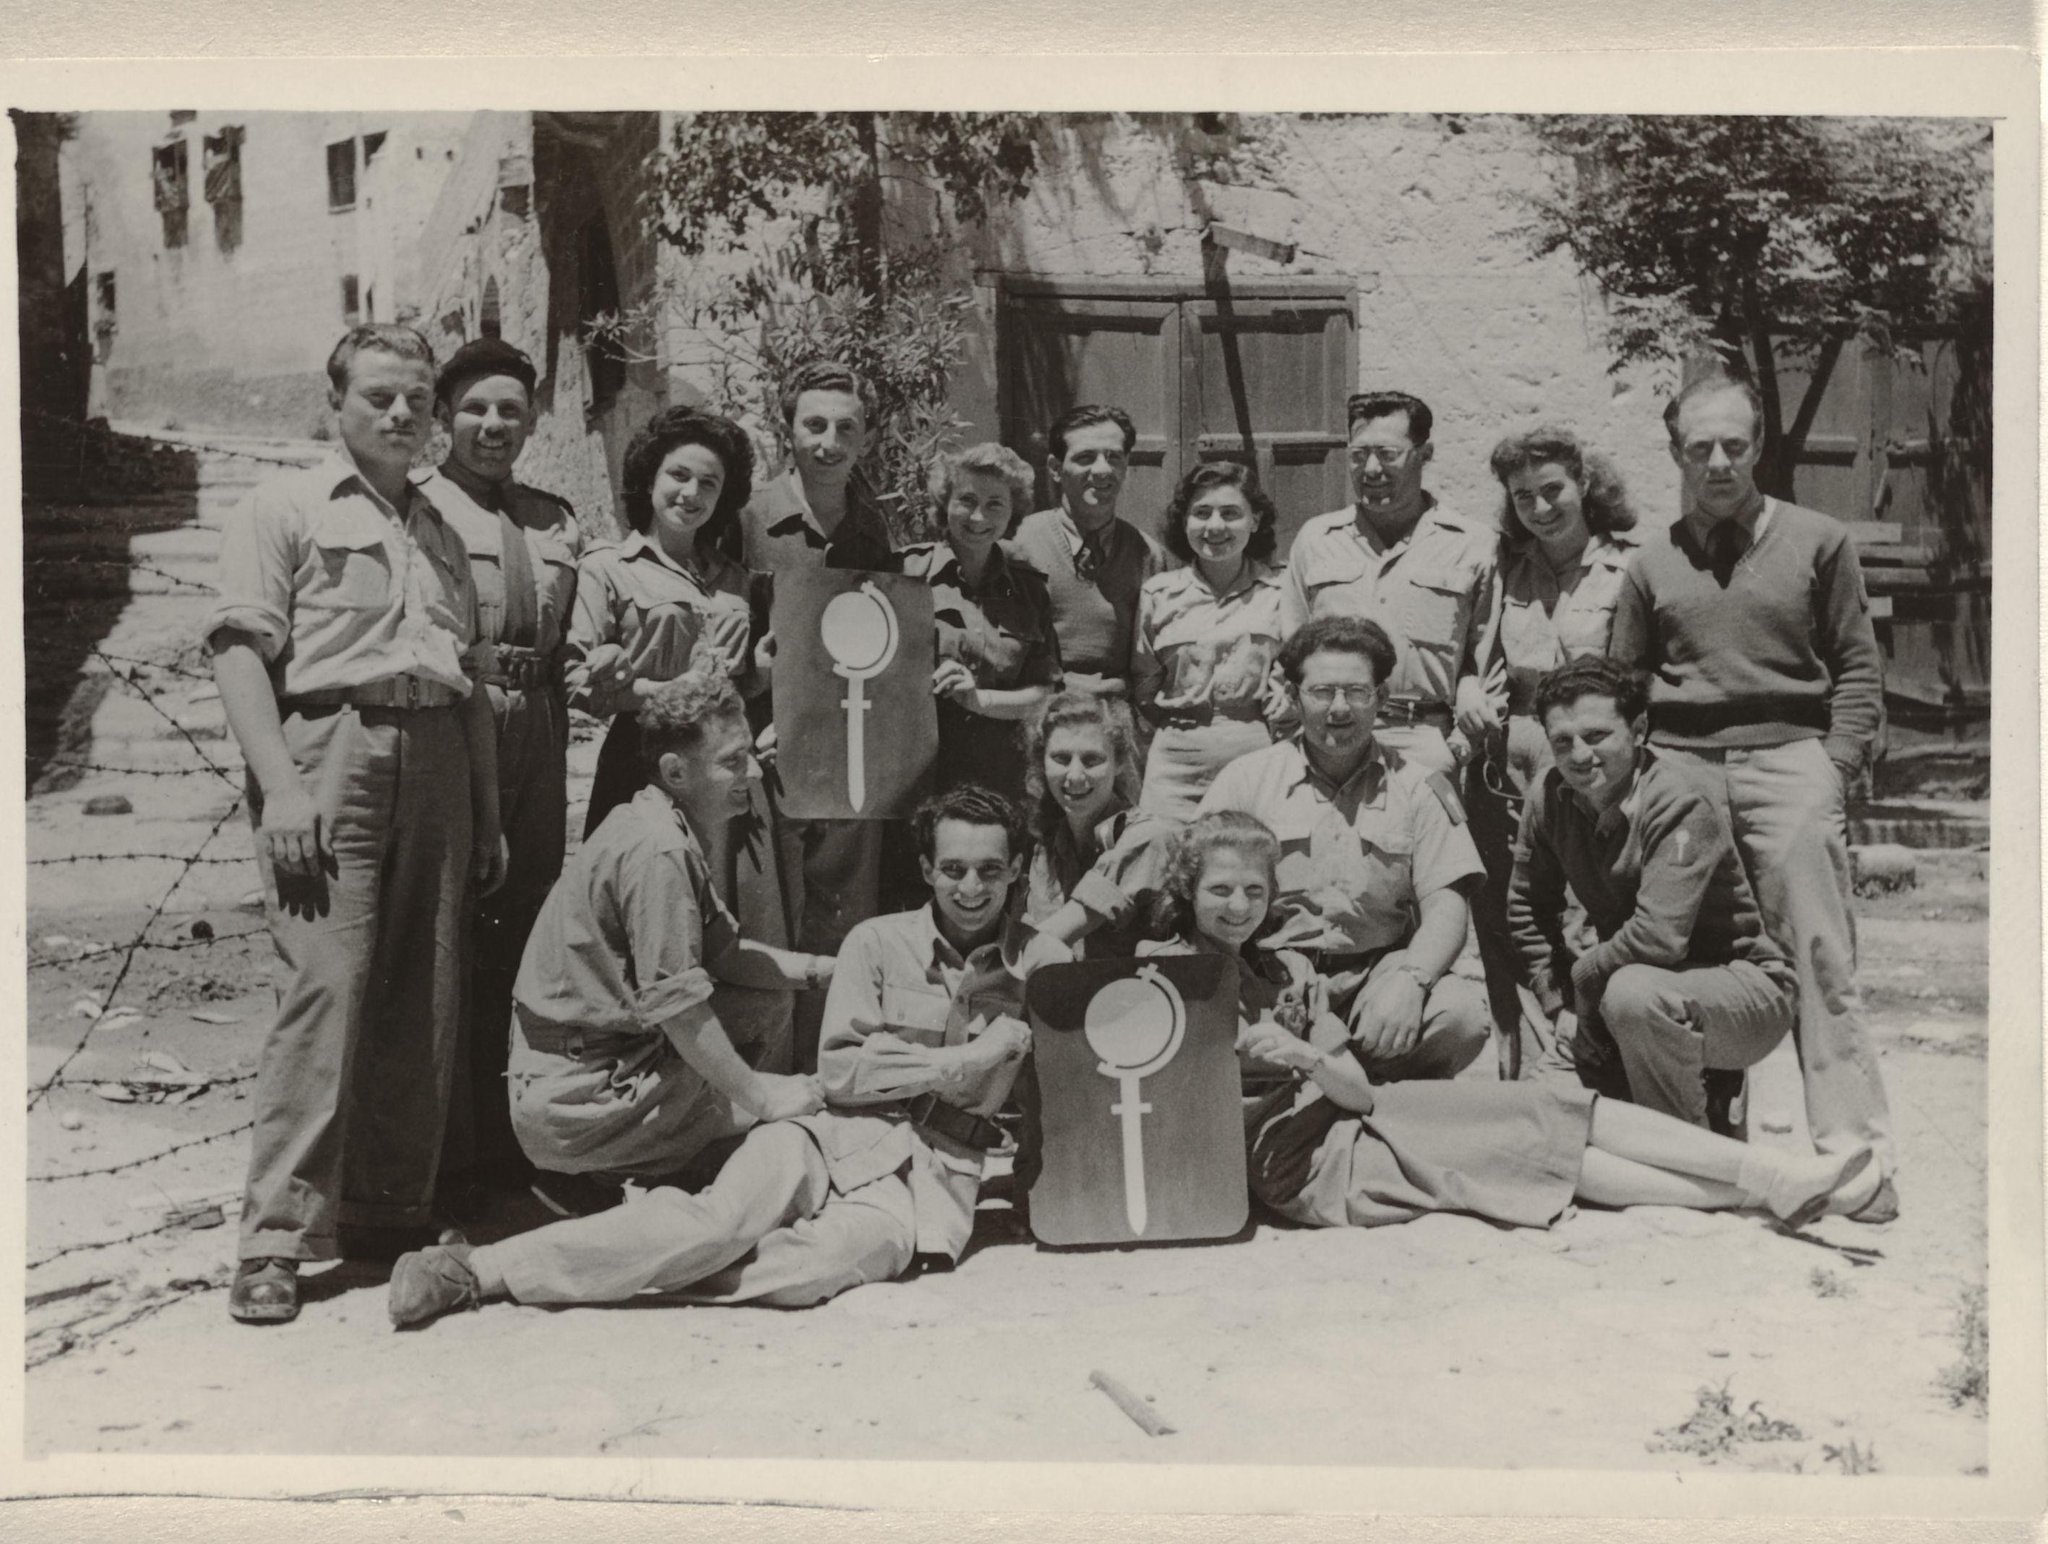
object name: photograph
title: Groepsportret van 15 onbekende mensen en Leo Blumensohn, met twee borden in de groep met daarop een zwaard dat een bal omringd, staand voor een afscheiding van prikkeldraad en een onbekend gebouw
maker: Anonymous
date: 1949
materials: photographic support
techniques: gelatin silver print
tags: leo blumensohn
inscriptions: inscription: ‘15.5.1949 Photo Chen 57. Rashi St. Tel-Aviv Erkannst Du uns alle Wieder?’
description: Groepsportret van 15 onbekende mensen en Leo Blumensohn (liggend, voorgrond met bord in de hand), met twee borden in de groep met daarop een zwaard dat een bal omringd, staand voor een afscheiding van prikkeldraad en een onbekend gebouw